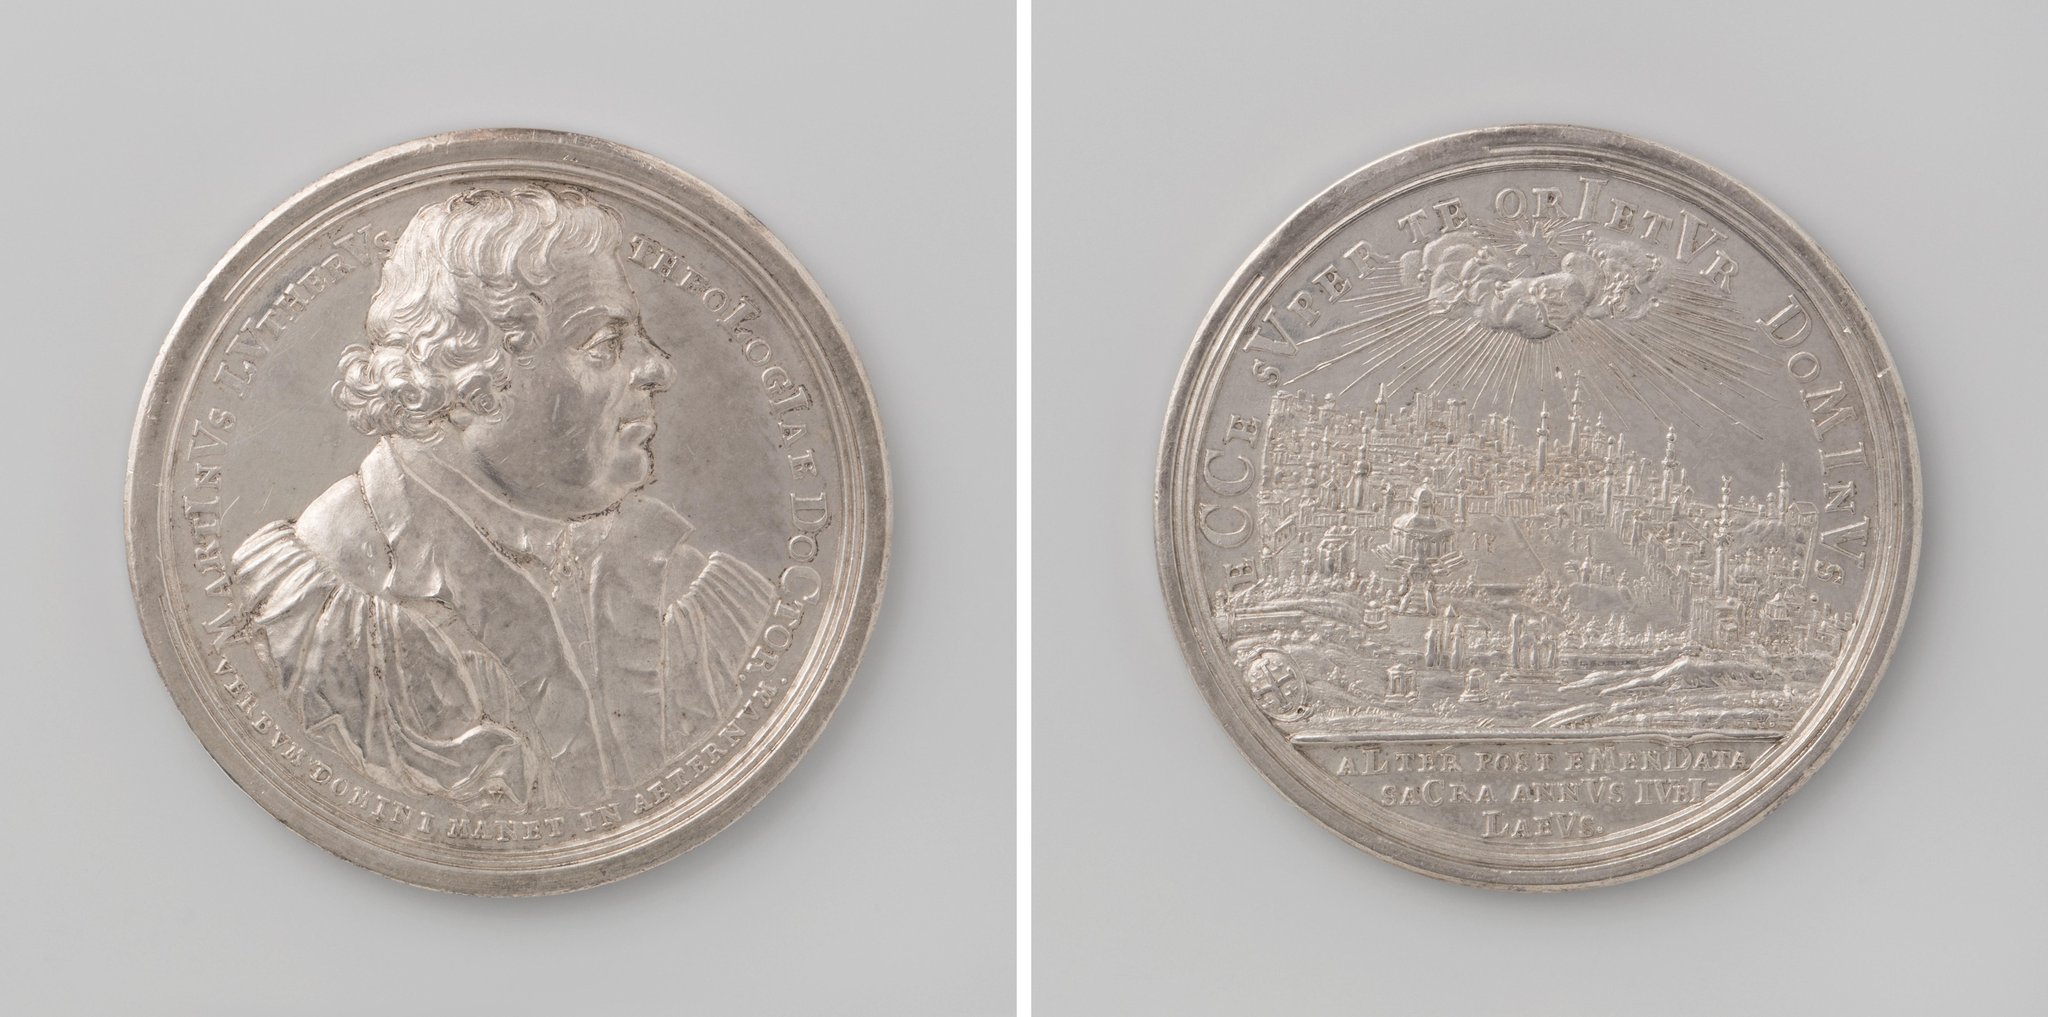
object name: history medal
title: Tweede eeuwfeest van de Reformatie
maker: georg wilhelm vestner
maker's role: medailleur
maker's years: 1677-1740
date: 1717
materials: silver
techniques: striking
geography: nuremberg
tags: priest, martin luther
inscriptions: caption: ‘ALTER POST EMENDATA/ SACRA ANNVS IVBIL/ AEVS.’, circumscription: ‘ECCE SVPER TE ORIETVR DOMINIVS’, circumscription: ‘MARTINUS LVTHERUS THEOLOGIAE DOCT.’, caption: ‘VERBVM DOMINI MANET IN AETERNVM.’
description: Zilveren penning. Voorzijde: borststuk man (Luther) binnen omschrift. Keerzijde: gezicht op een stad (het nieuwe Jeruzalem), daarboven stralende ster boven wolken en engelen, op voorgrond wapenschild van stad binnen omschrift; afsnede: opschrift.